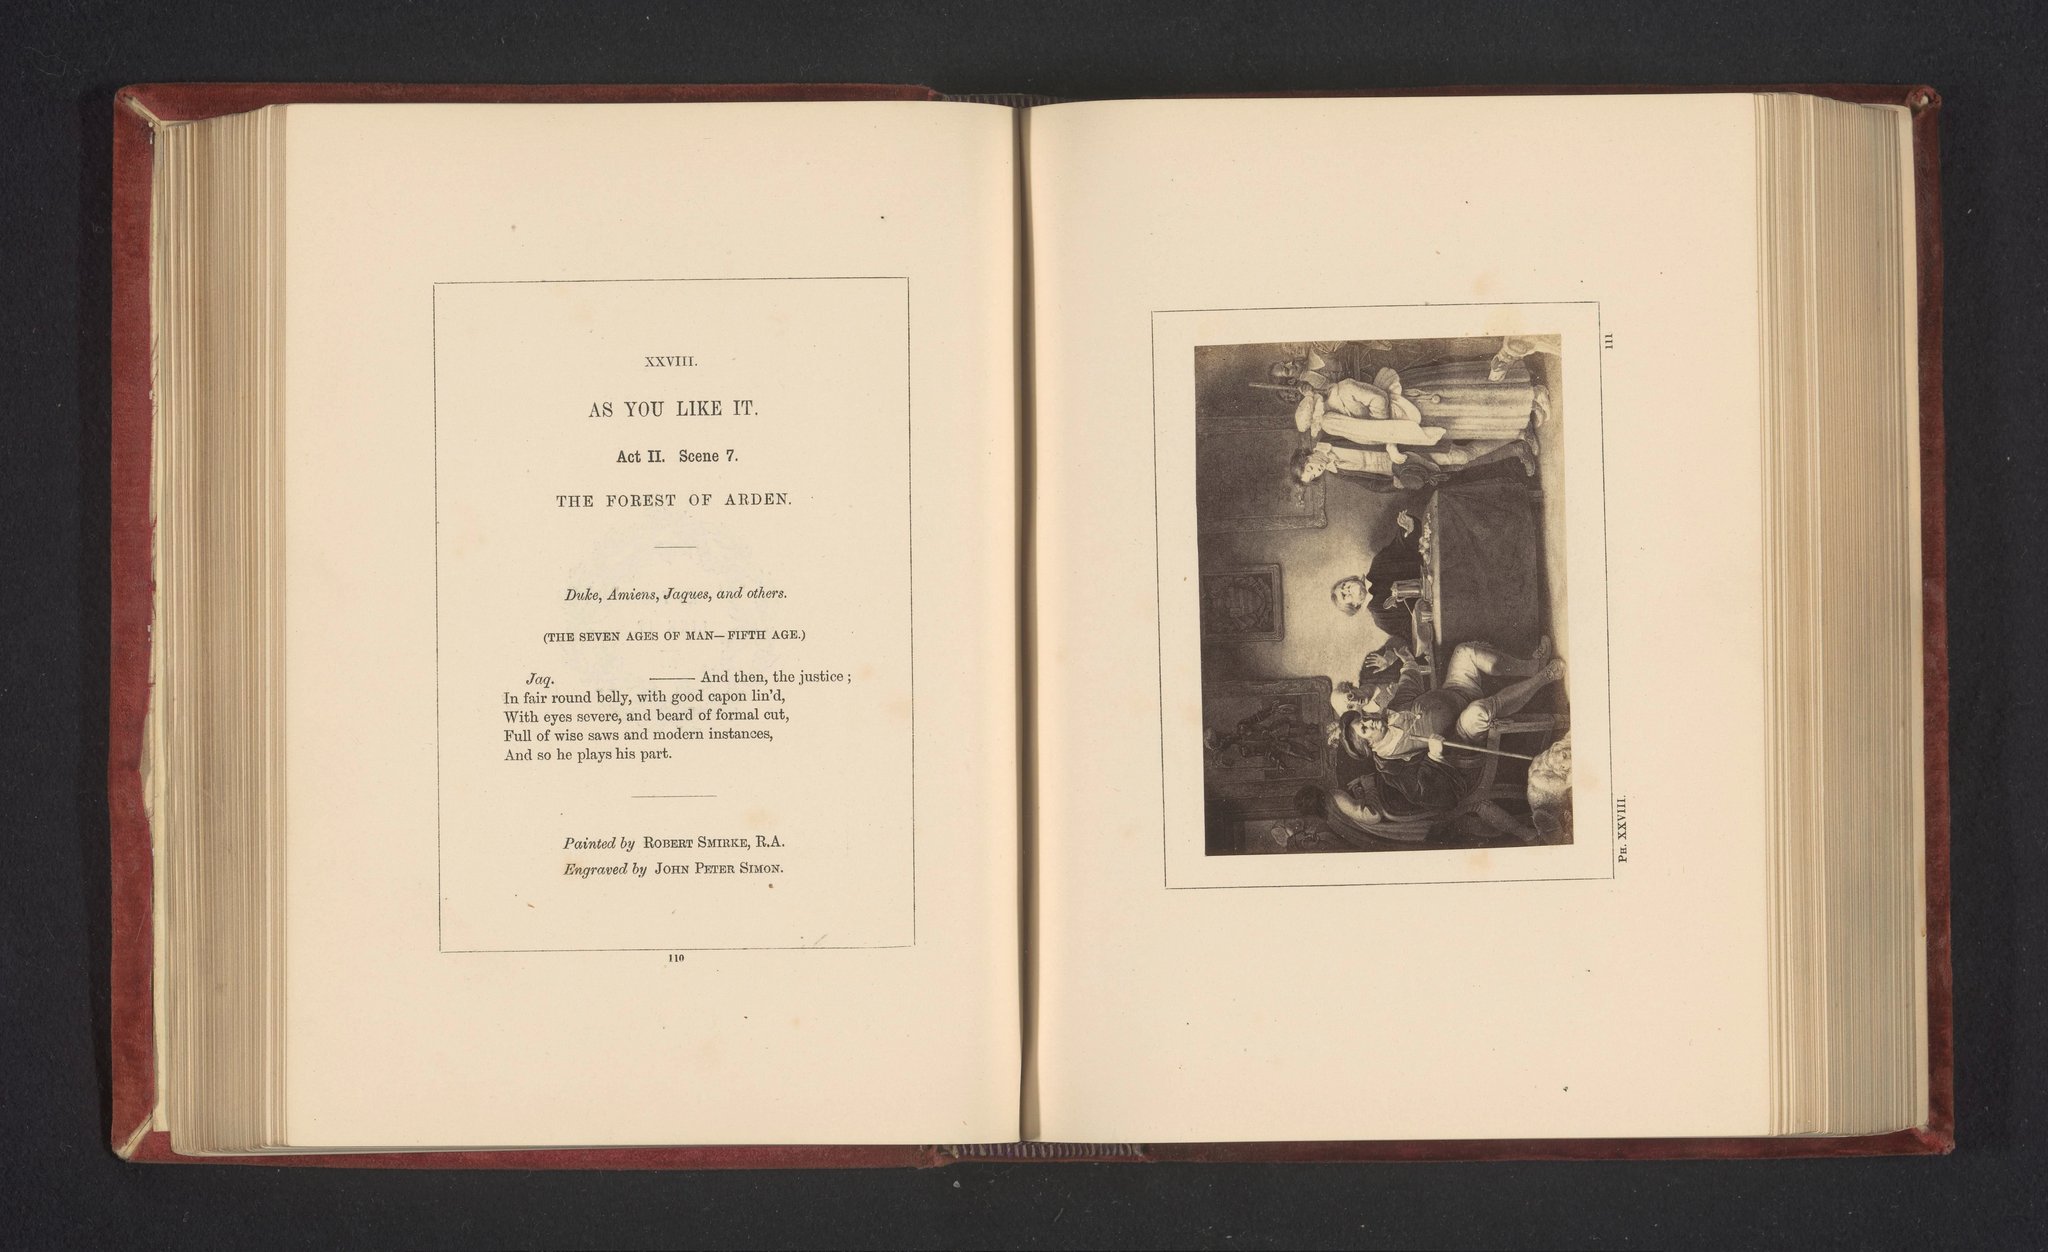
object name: photograph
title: Fotoreproductie van een prent naar een schilderij door Robert Smirke, voorstellend een scene uit Naar het u bevalt door William Shakespeare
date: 1854-1864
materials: photographic support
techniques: albumen print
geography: london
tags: specific works of literature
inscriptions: number: ‘Ph. XXVIII. 111’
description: Te zien is een verbeelding van akte II, scene 7; Seven Ages Of Man.